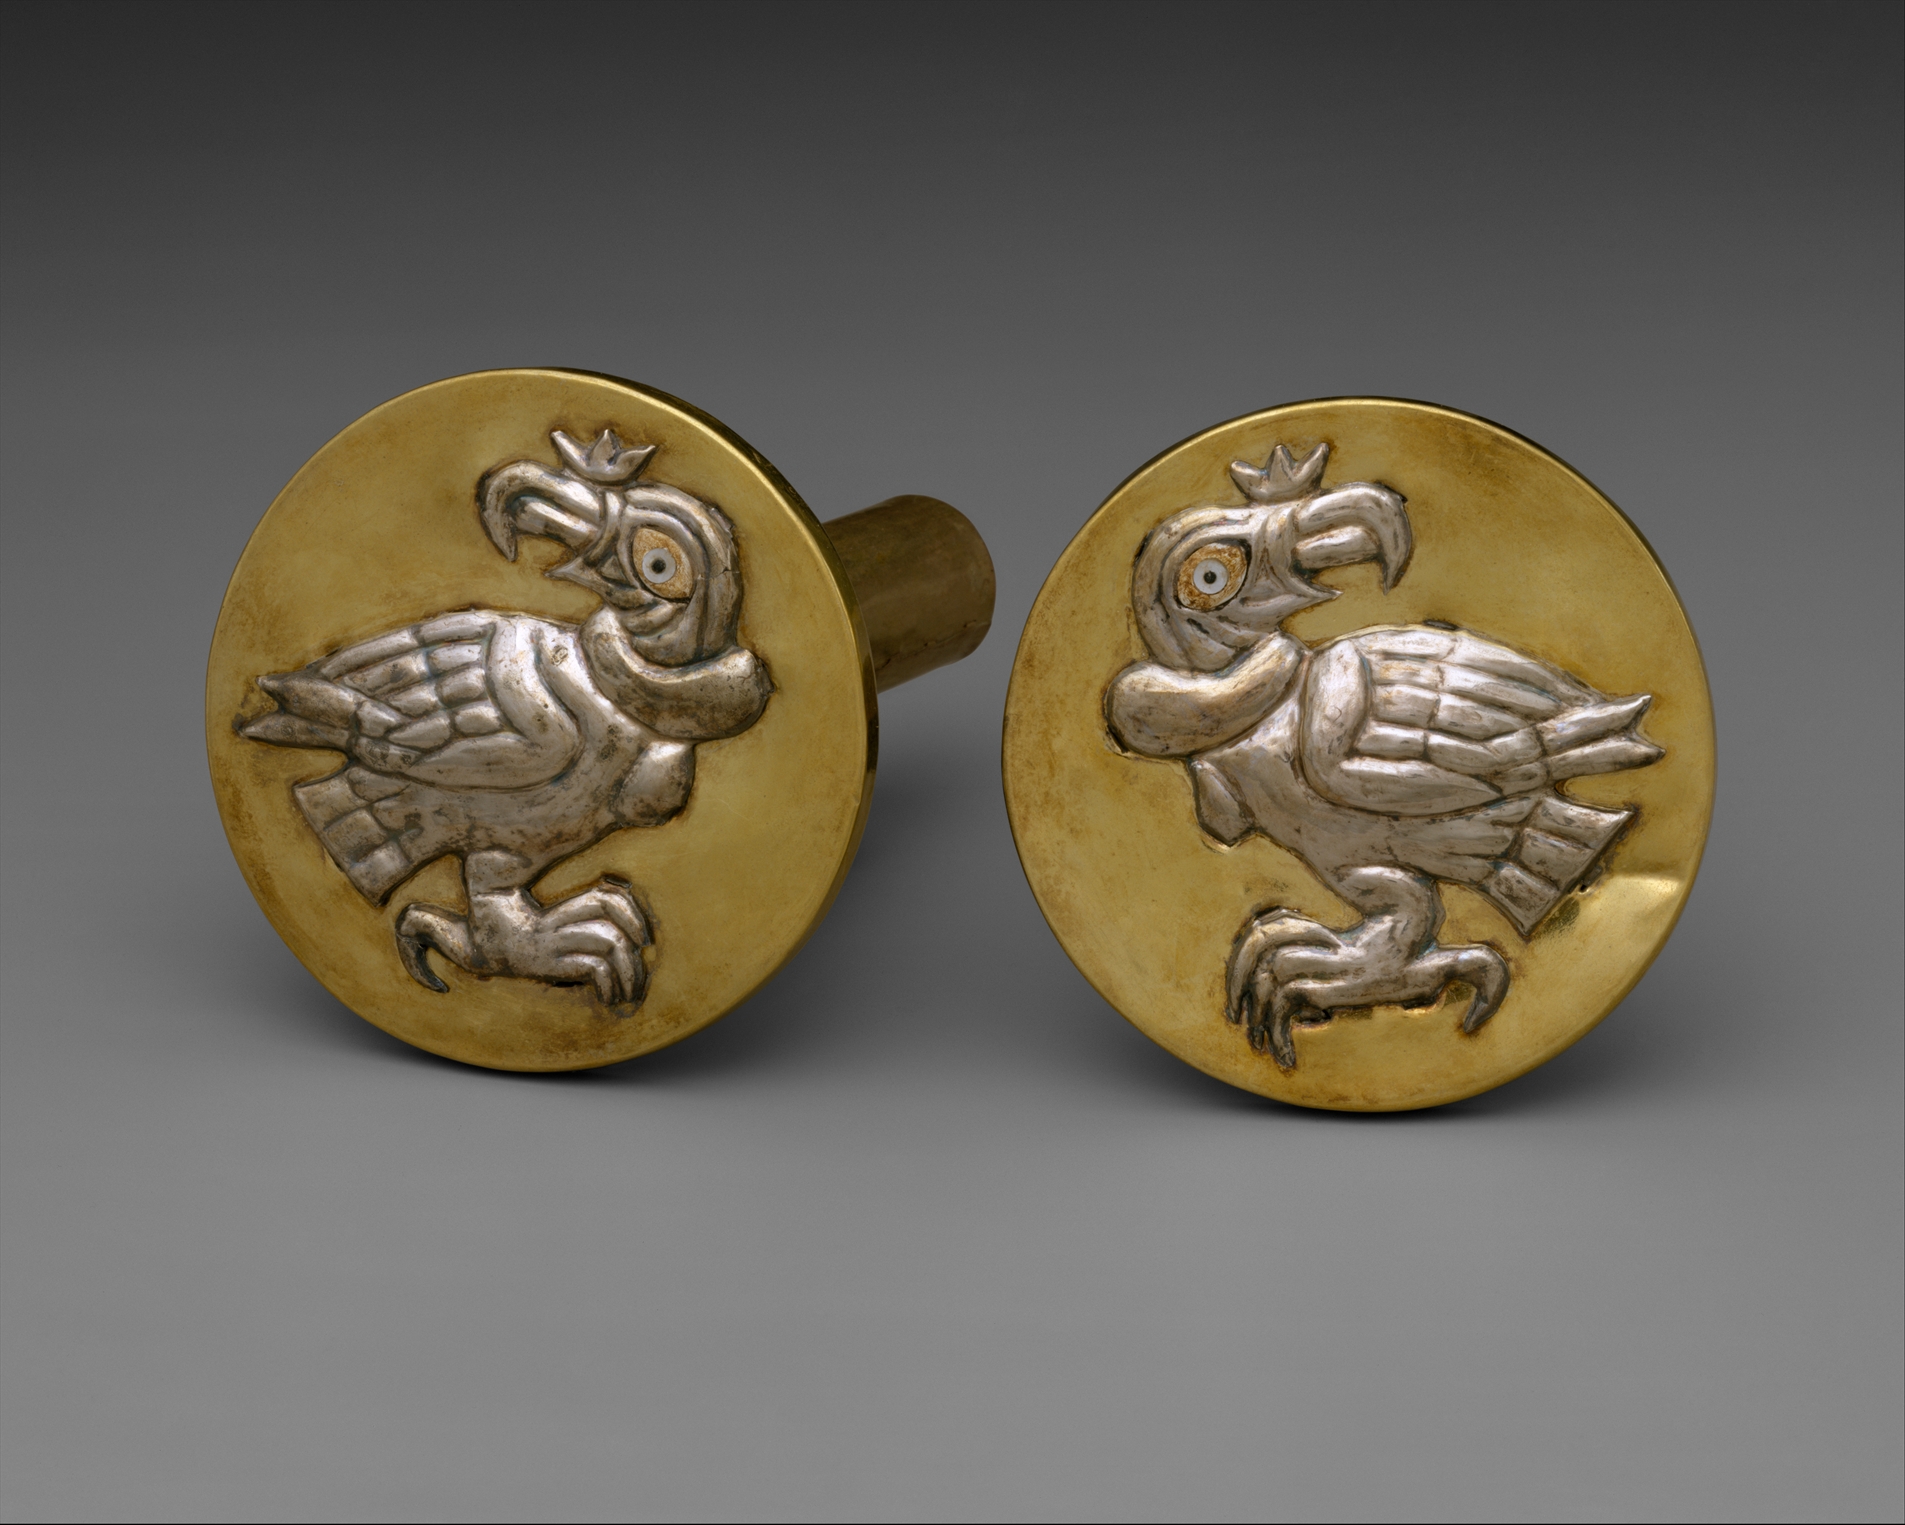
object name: earflare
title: Pair of earflares with condors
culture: moche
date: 501-700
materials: gilt copper, gold, shell, silver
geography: peru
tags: birds